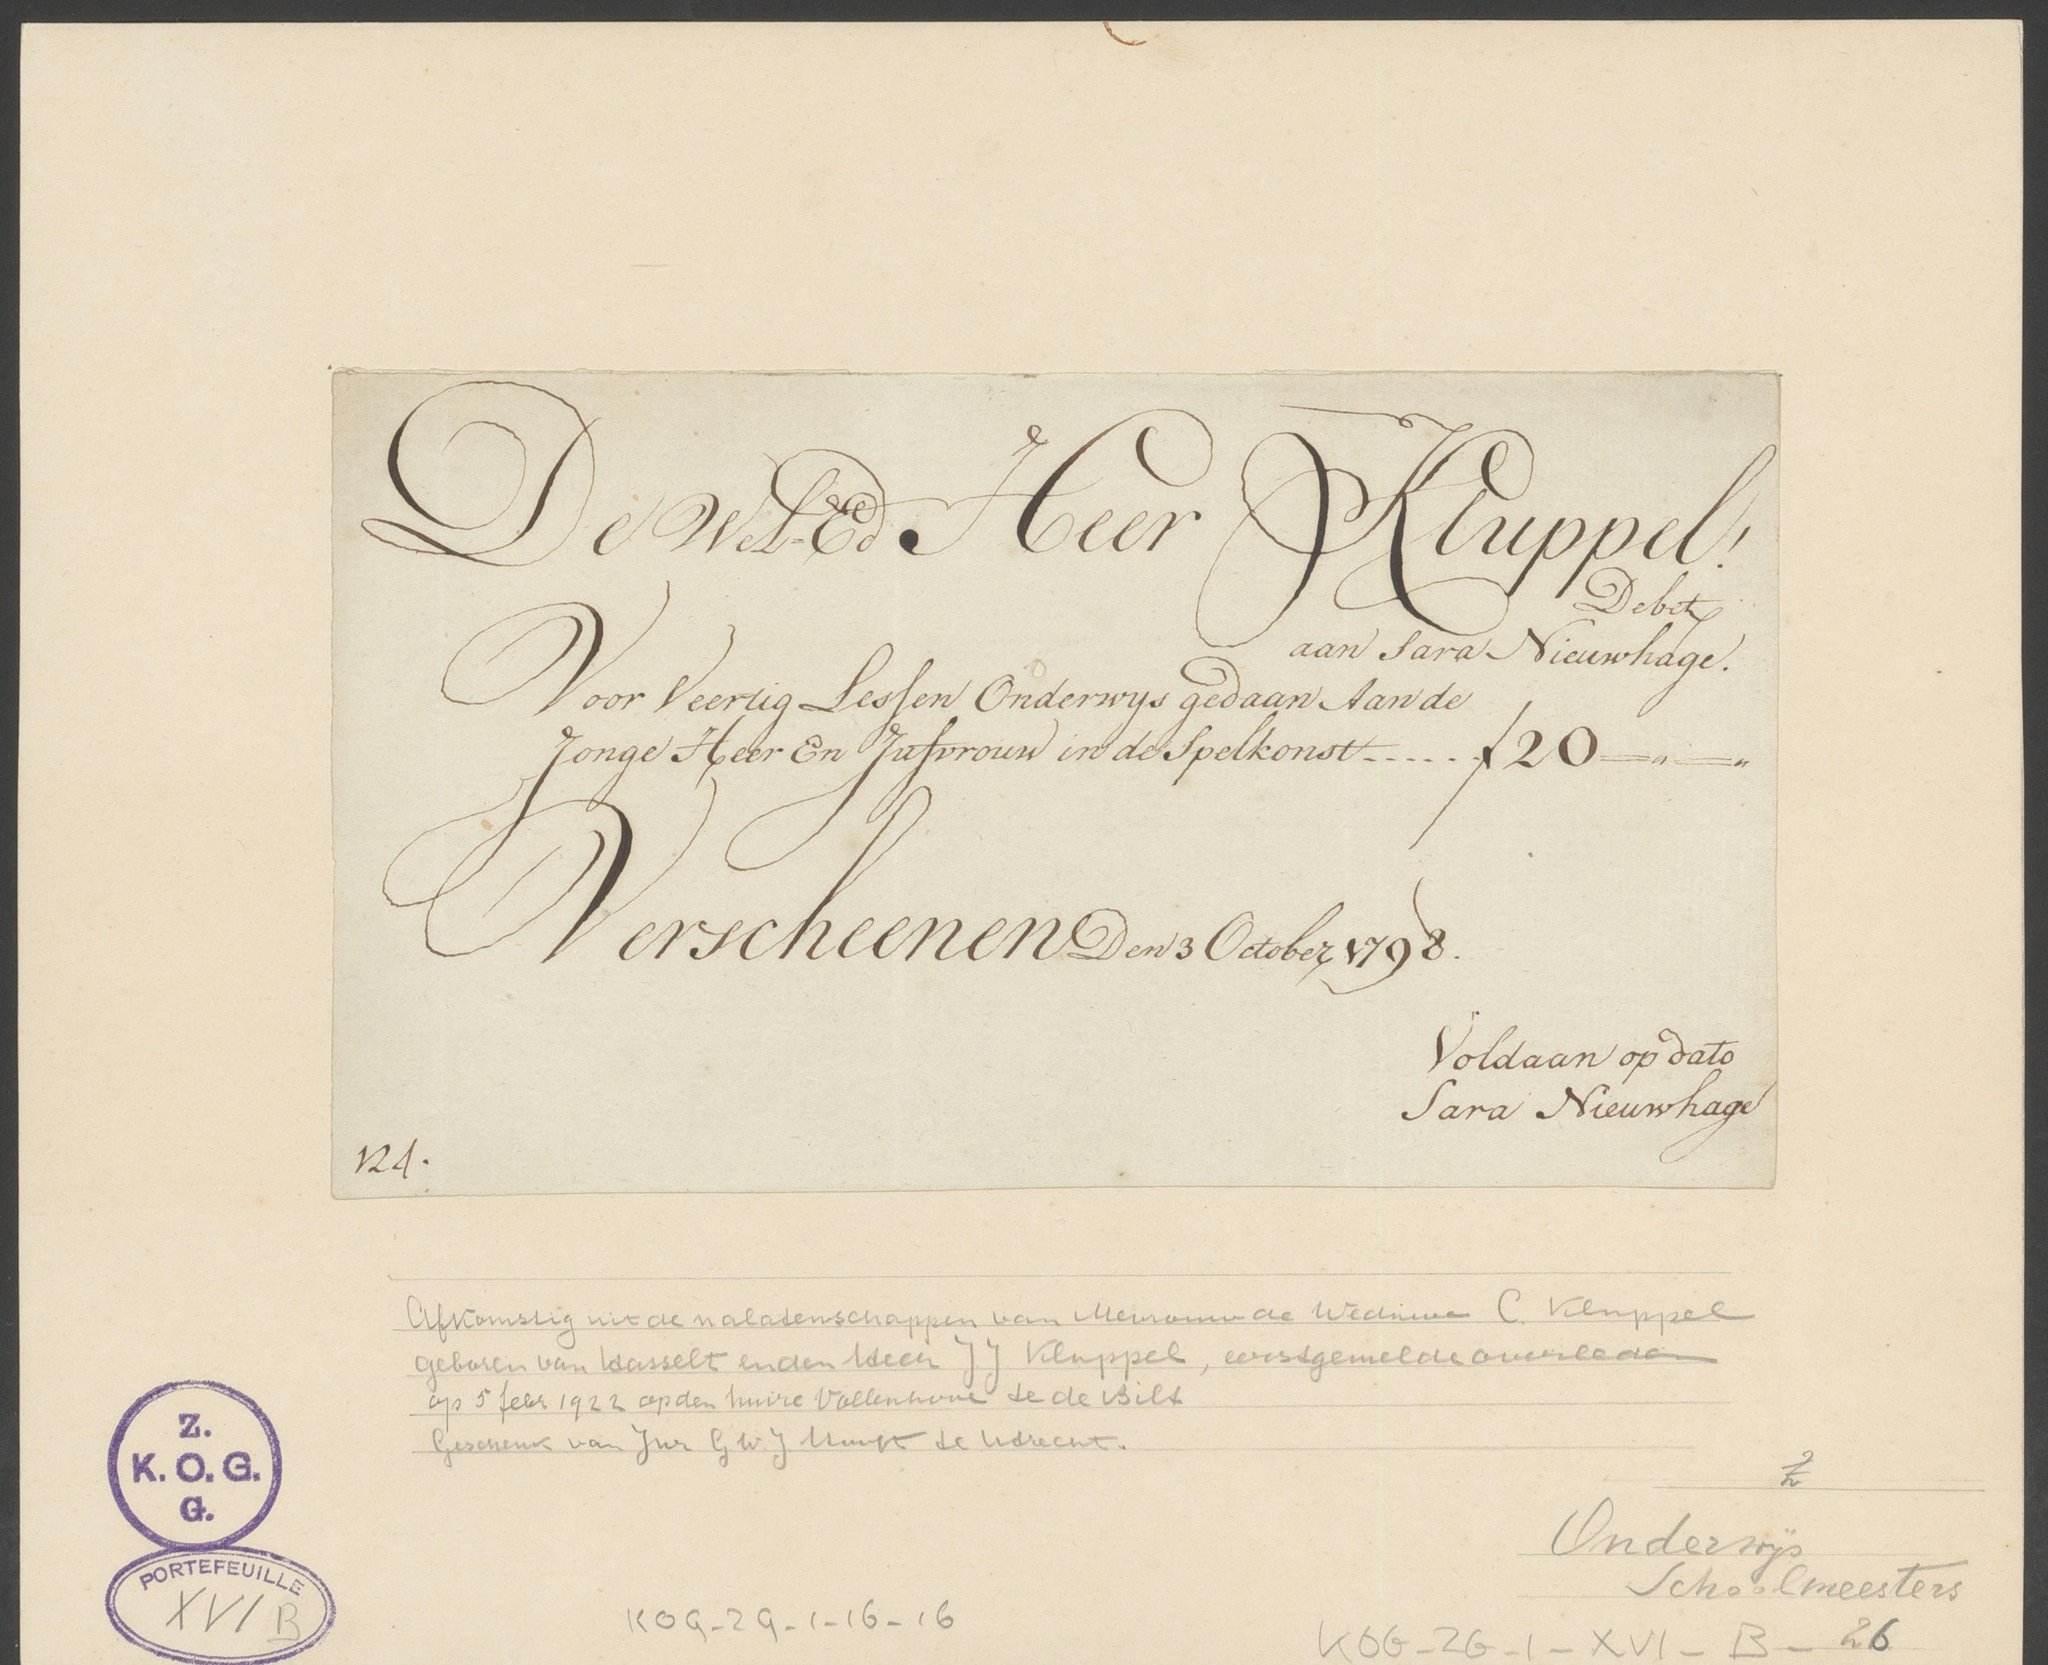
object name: account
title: Rekening voor 40 lessen in de spelkunst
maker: Anonymous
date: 1798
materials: ink, paper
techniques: pen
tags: linguistics, professor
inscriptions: stamp, collector's mark: Lugt 1641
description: Rekening voor 40 lessen in de spelkunst door de heer Kluppel aan een jongen en Sara Nieuwhage. Onderwerpsrubrieken binnen de Atlas Zeden en Gewoonten: Onderwijs en Wetenschappen, Opvoeding en Onderwijs, Schoolmeesters.